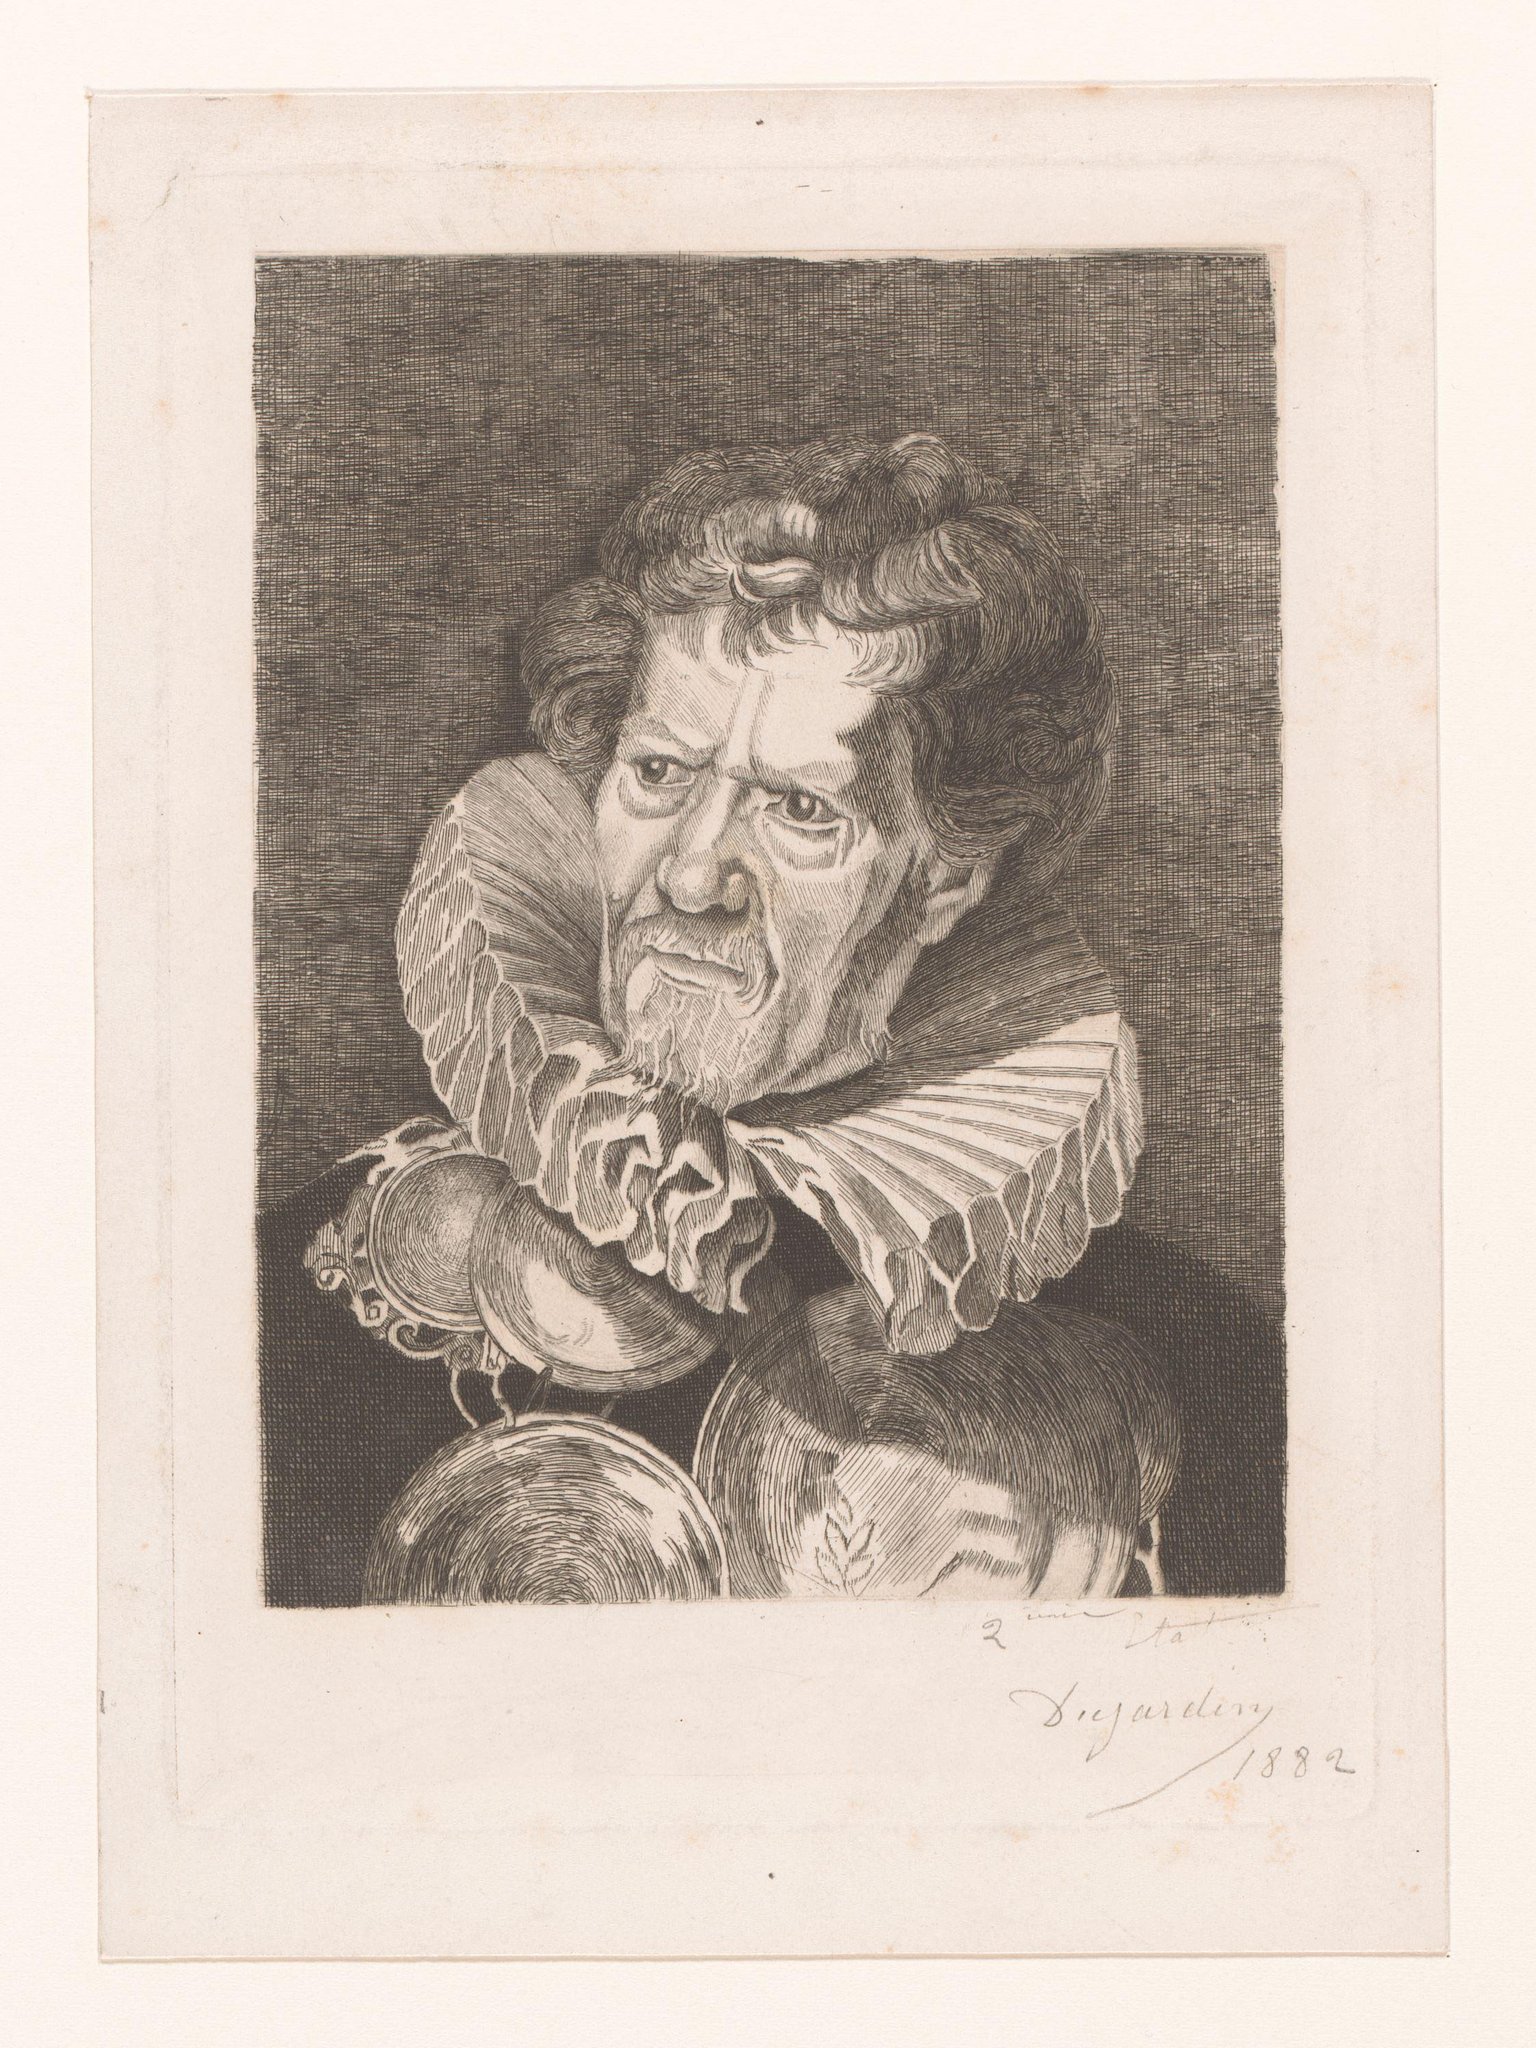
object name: print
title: Portret van Abraham Grapheus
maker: joseph dujardin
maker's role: print maker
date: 1882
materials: paper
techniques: etching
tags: adult man, historical persons, antwerp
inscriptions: collector's mark: Lugt 2228, inscription: ‘2eme Etat’